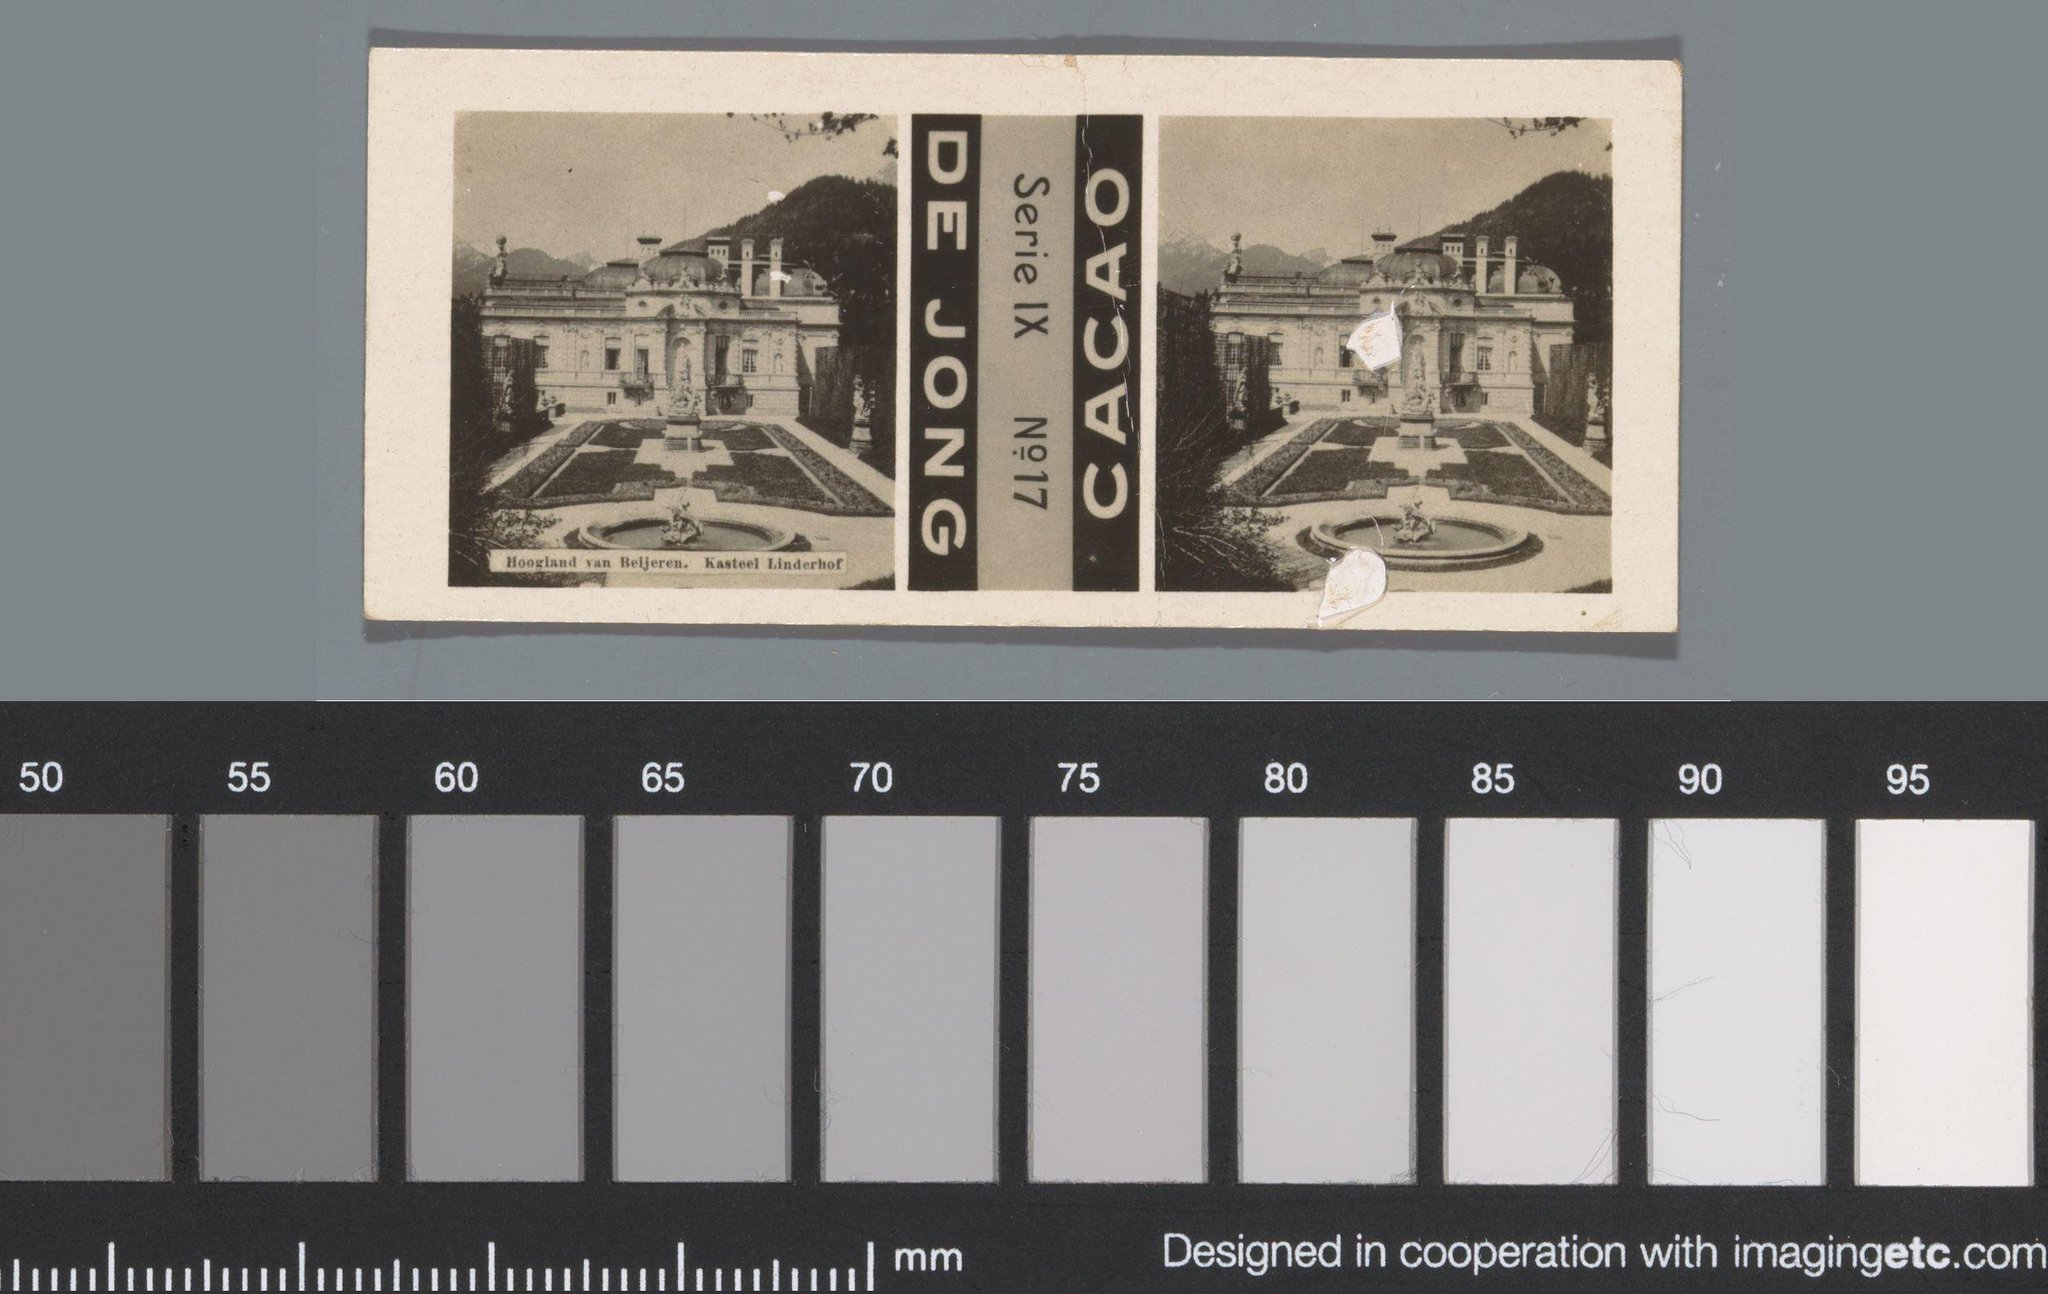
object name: stereograph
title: Exterieur van Slot Linderhof te Ettal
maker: Anonymous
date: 1900-1910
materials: cardboard, photographic support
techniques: gelatin silver print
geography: bavaria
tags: palace, façade (of house or building)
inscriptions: inscription: ‘De Jong Chocolat’, number: ‘Serie IX No. 17’